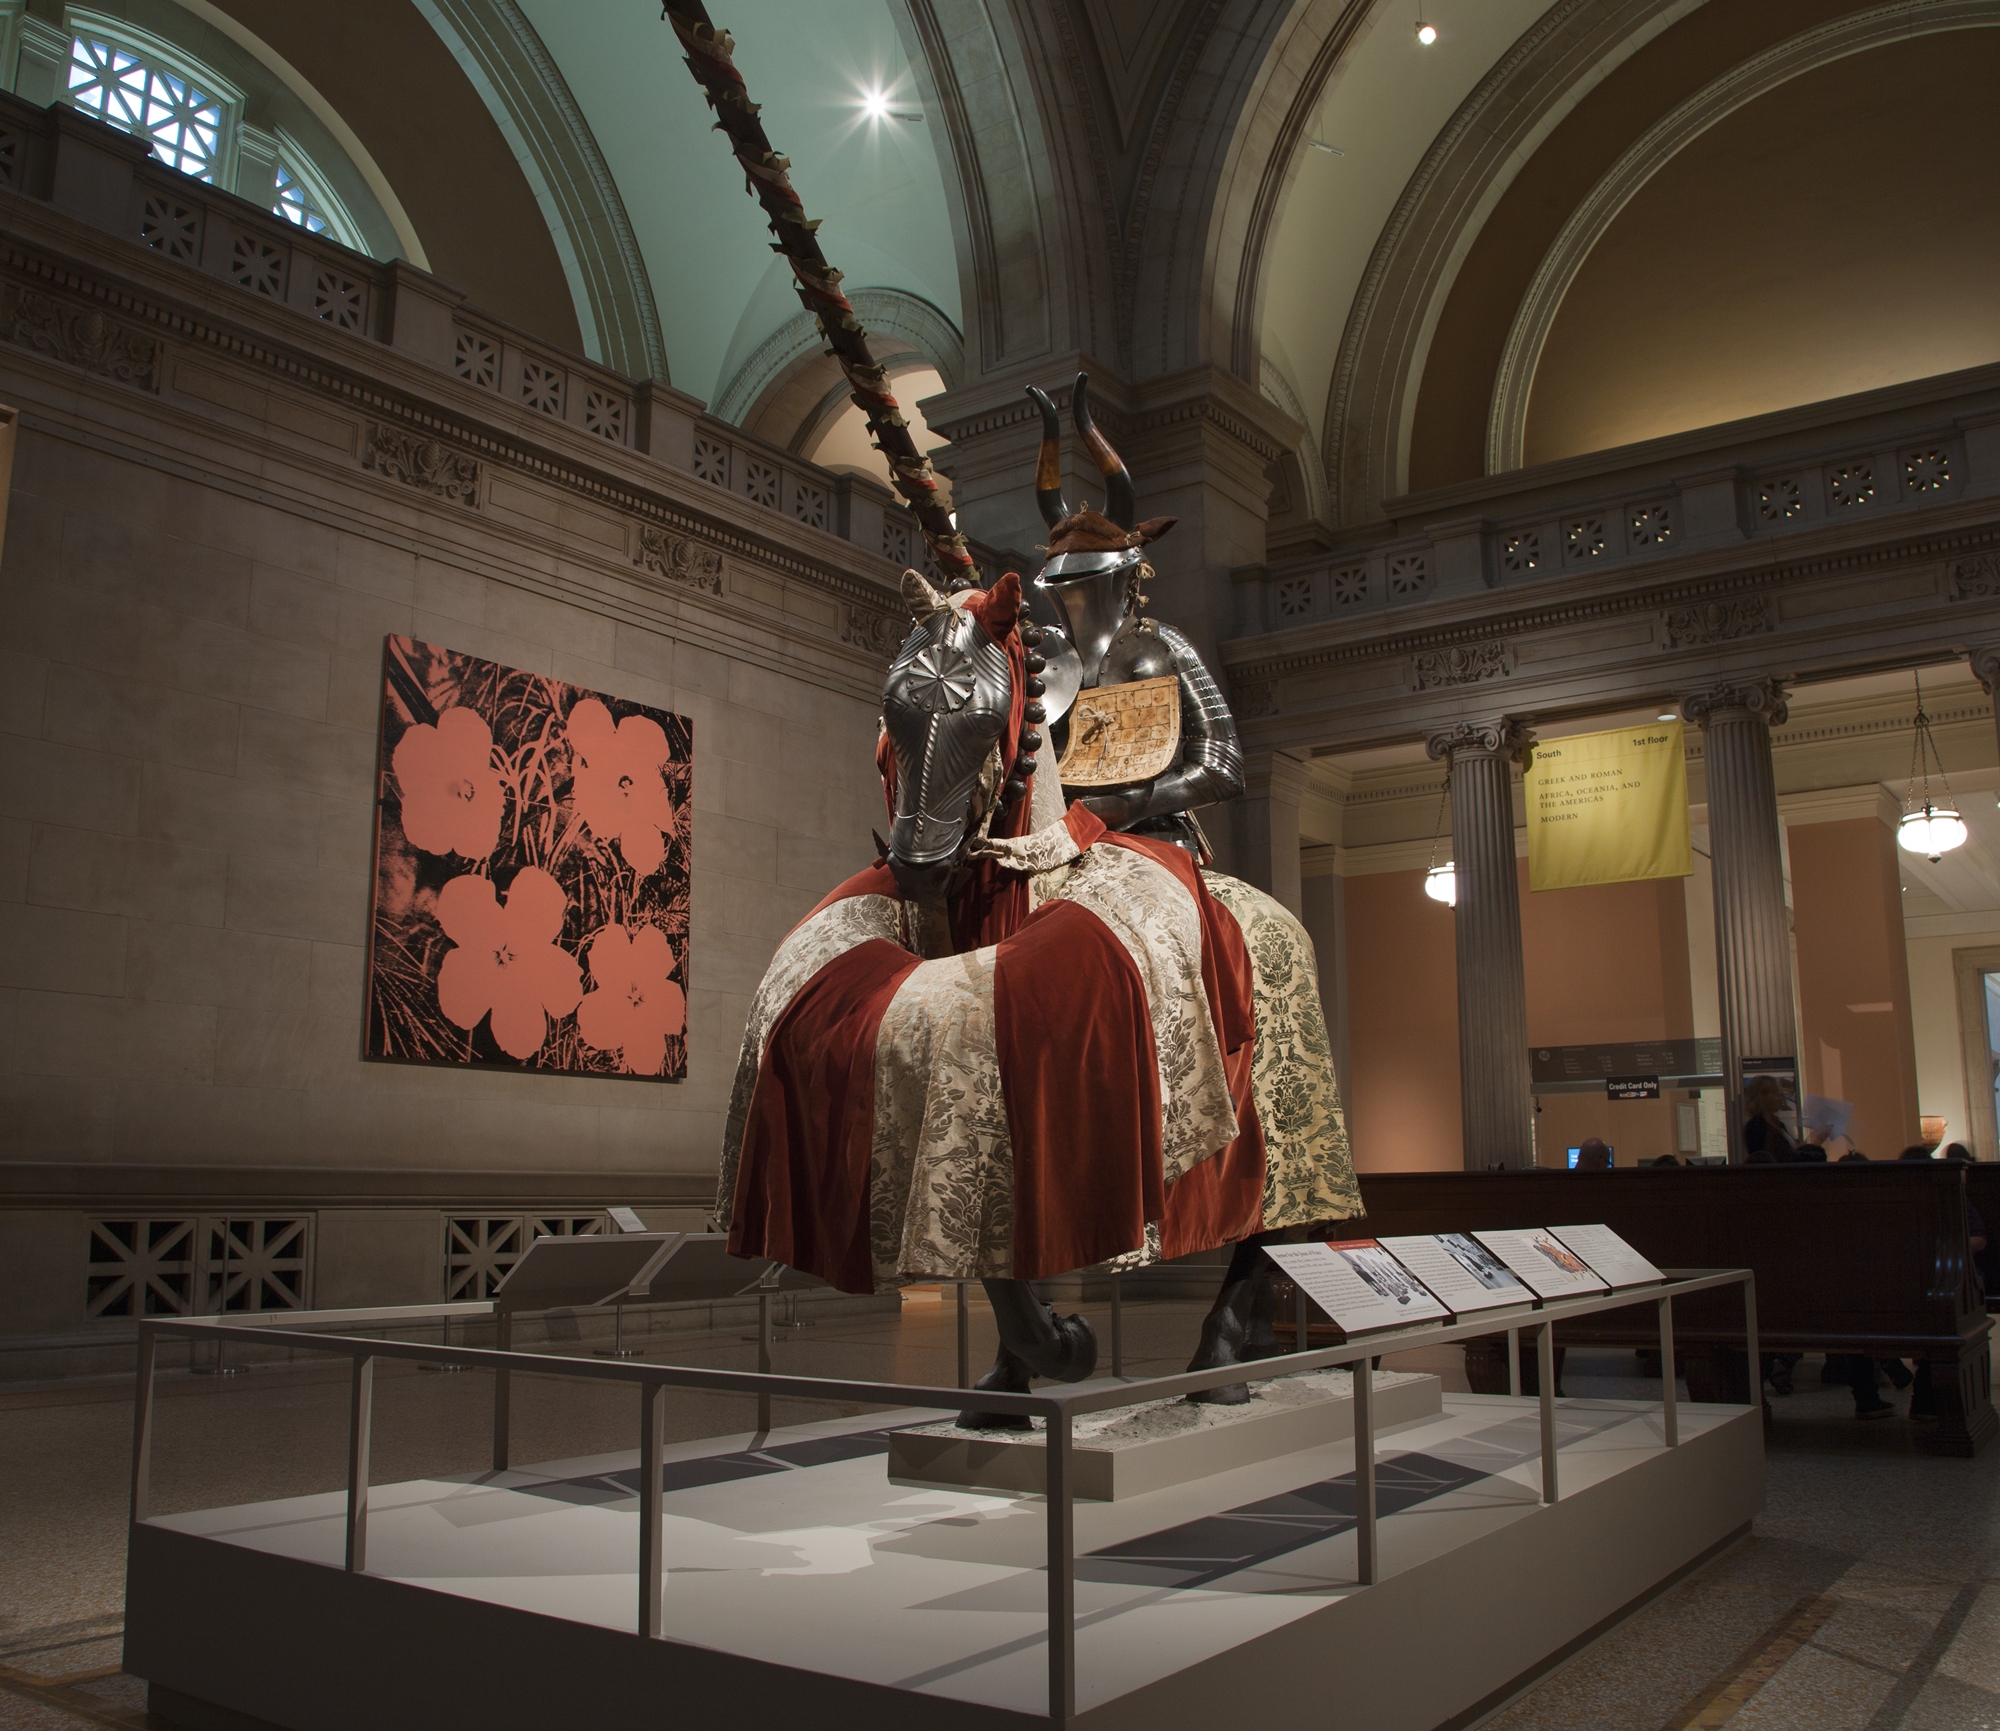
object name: jousting armor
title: Armor for the Joust of Peace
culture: german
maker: daniel tachaux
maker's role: armorer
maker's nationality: french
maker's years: 1857-1928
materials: copper alloy, horn, leather, steel, textile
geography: france